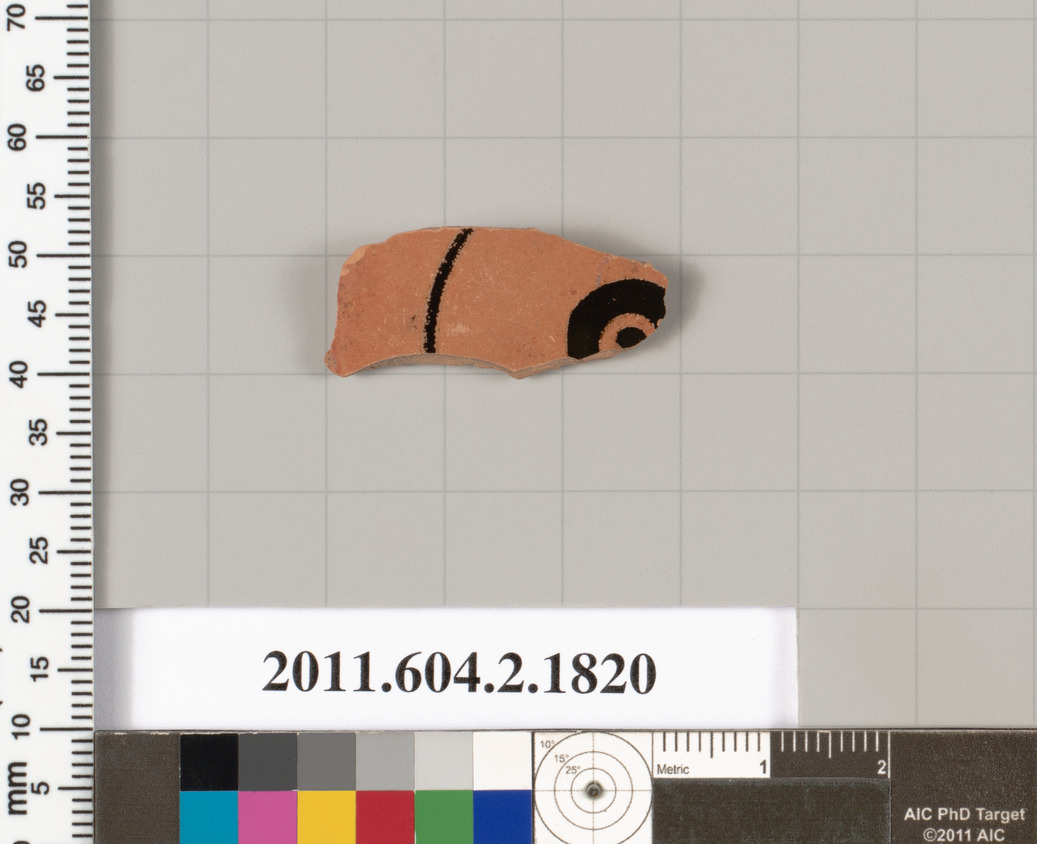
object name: skyphos fragment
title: Terracotta fragment of a skyphos (deep drinking cup)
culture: greek, attic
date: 467-435 BCE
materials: terracotta